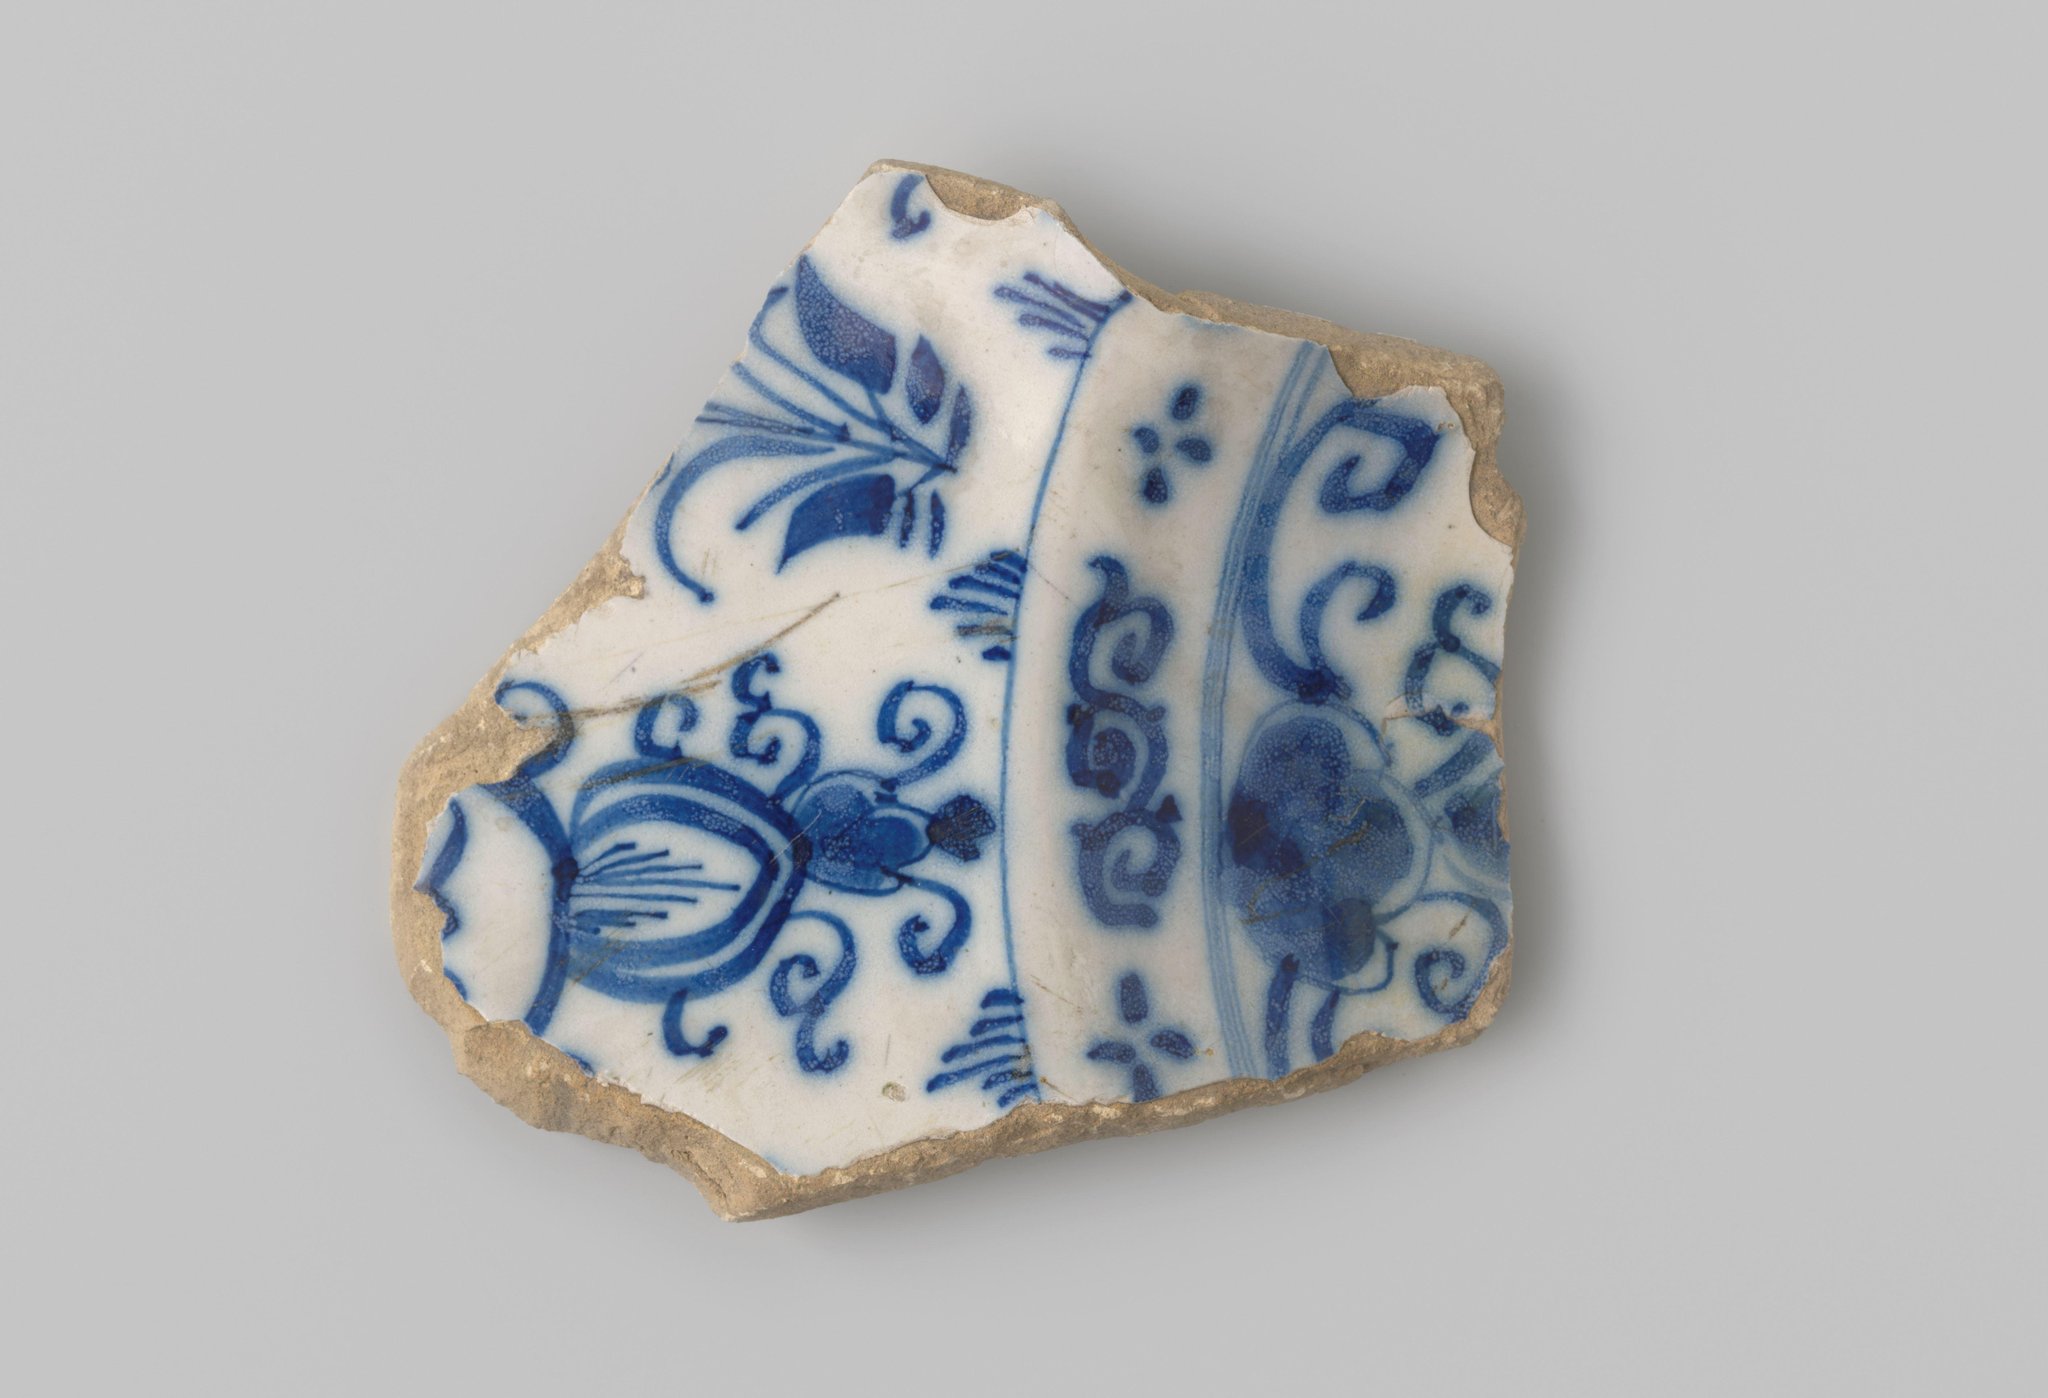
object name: sherd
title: Scherf van witbakkend aardewerk, met aan de voorzijde een decor van onder andere bloemen in blauw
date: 1500-1899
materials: earthenware, glaze